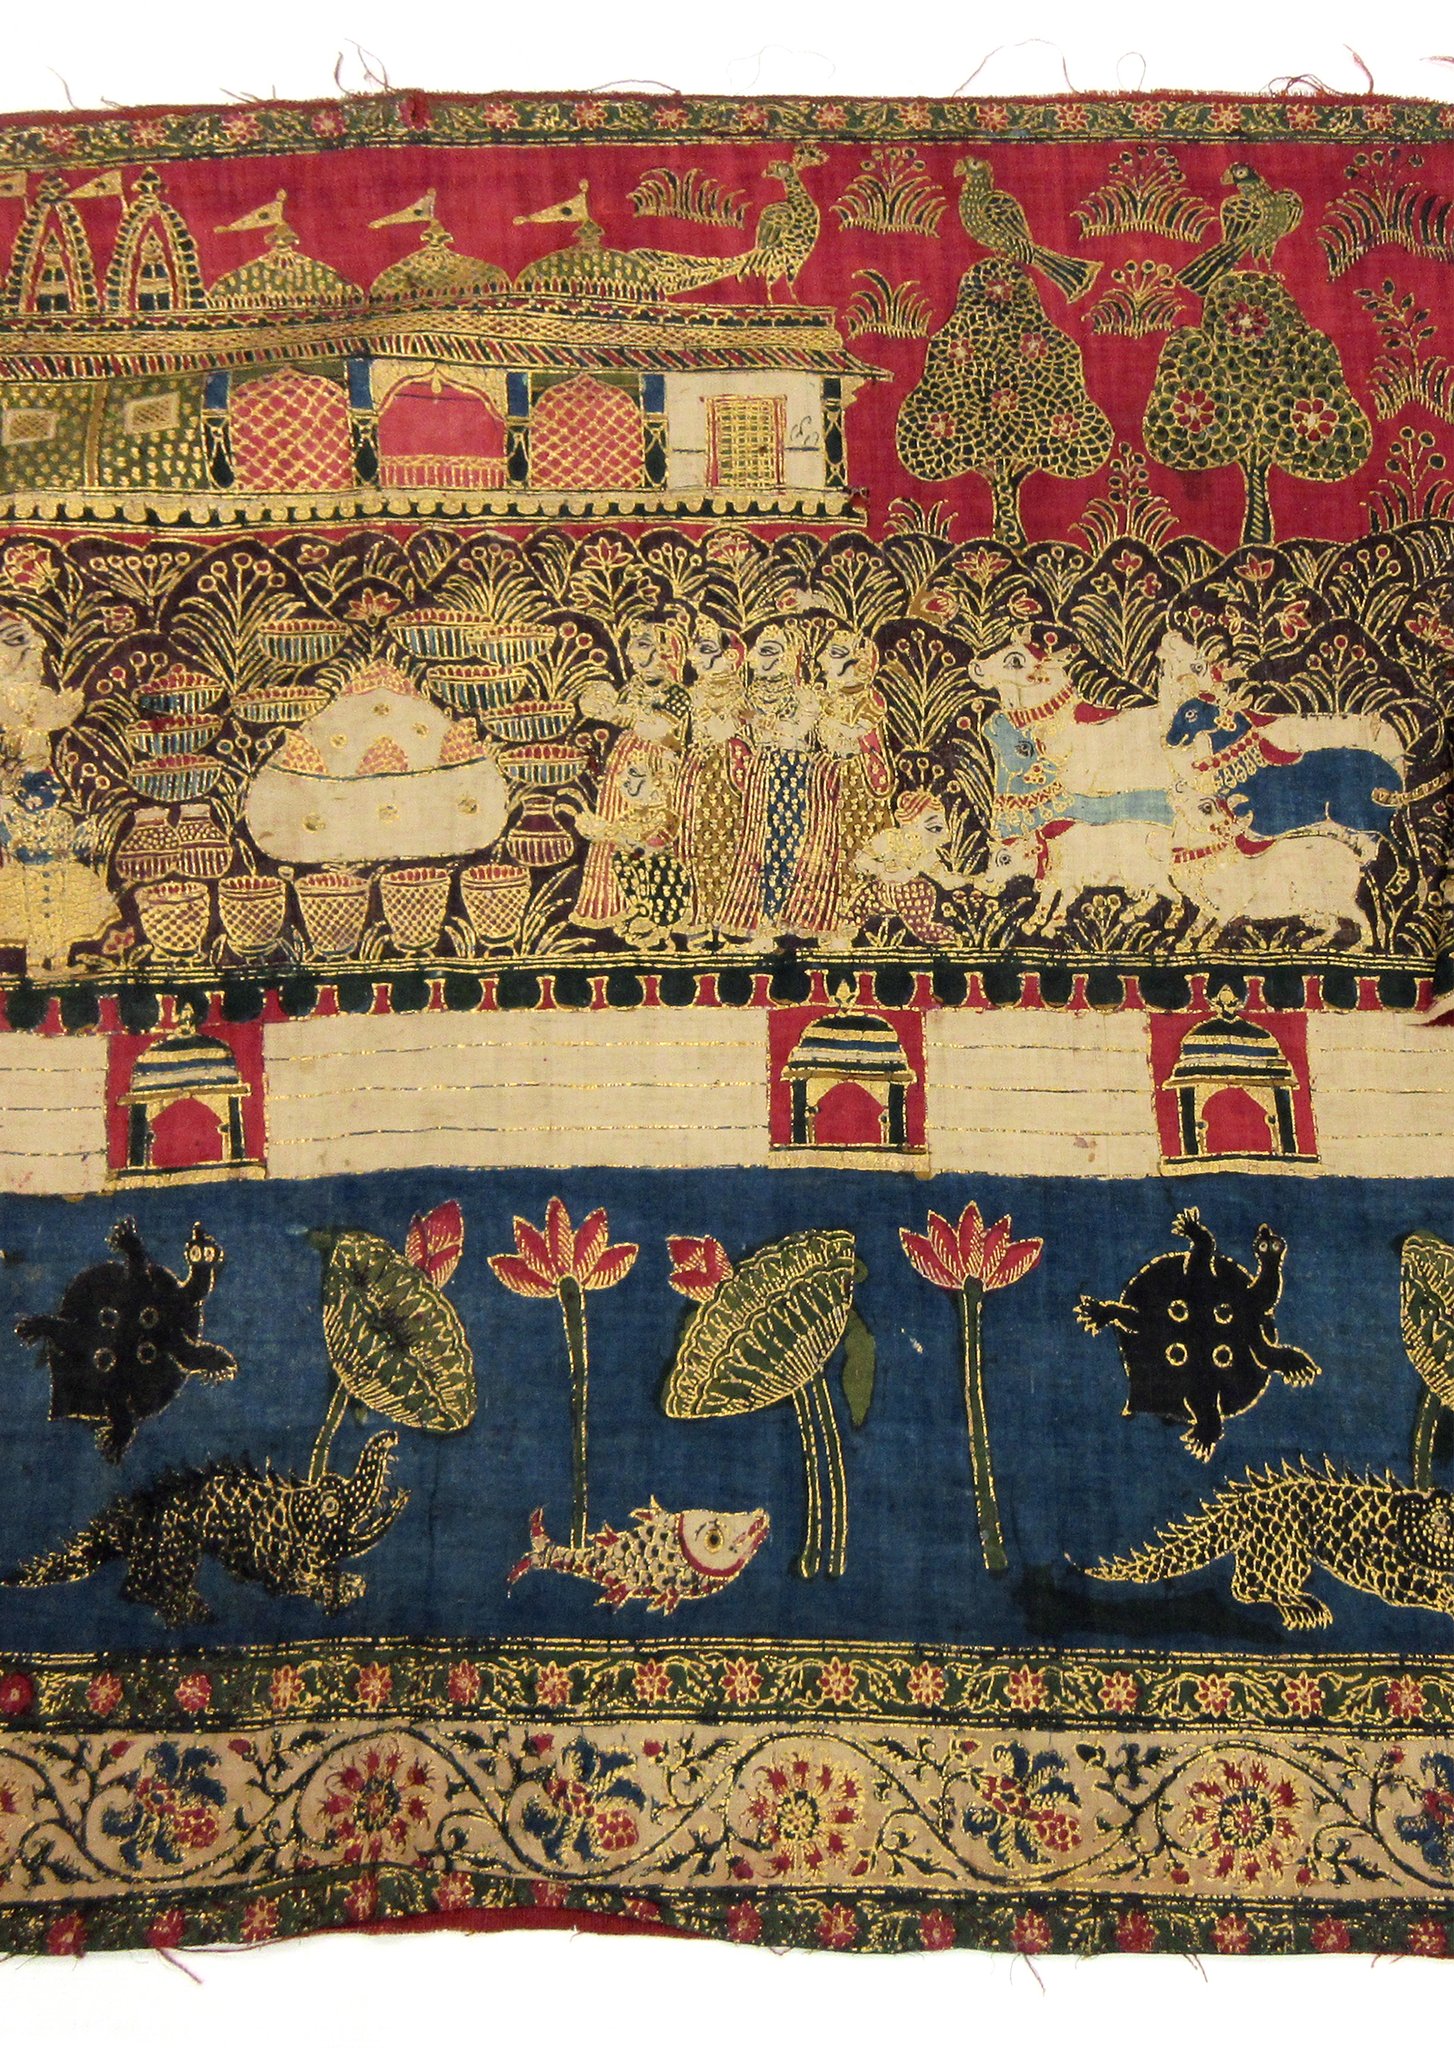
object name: hanging, temple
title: Temple cloth celebrating Krishna (Picchavai) (border section)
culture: indian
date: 1767-1800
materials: cotton, gold, pigment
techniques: painting